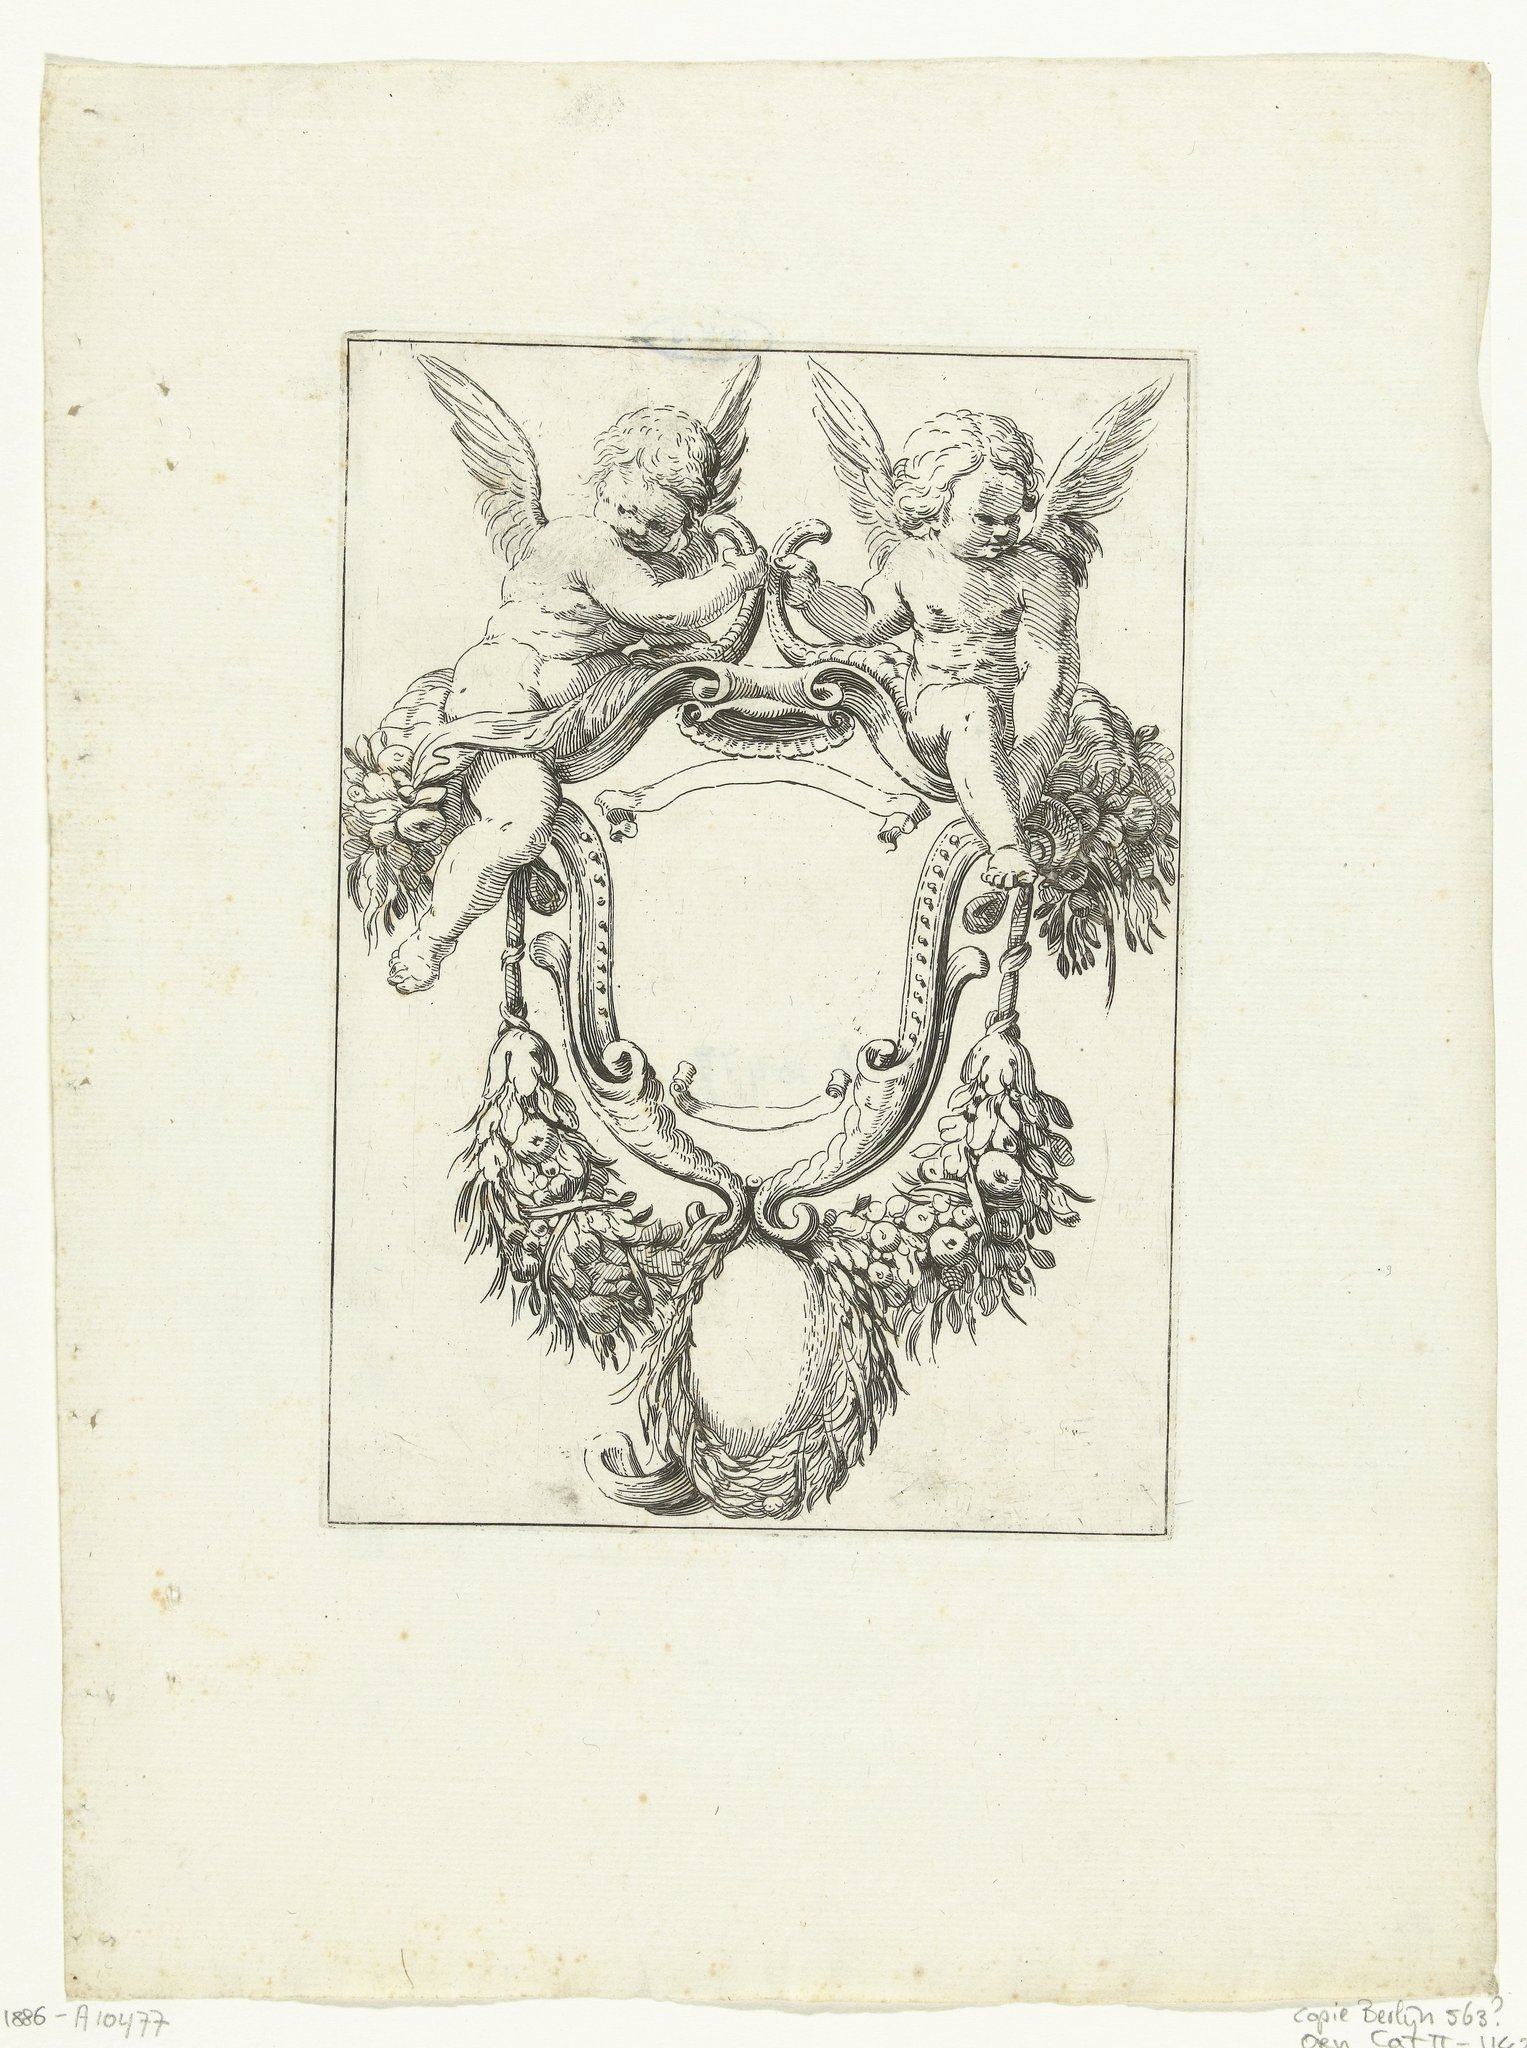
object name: ornament print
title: Cartouches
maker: Anonymous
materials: paper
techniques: engraving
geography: italy